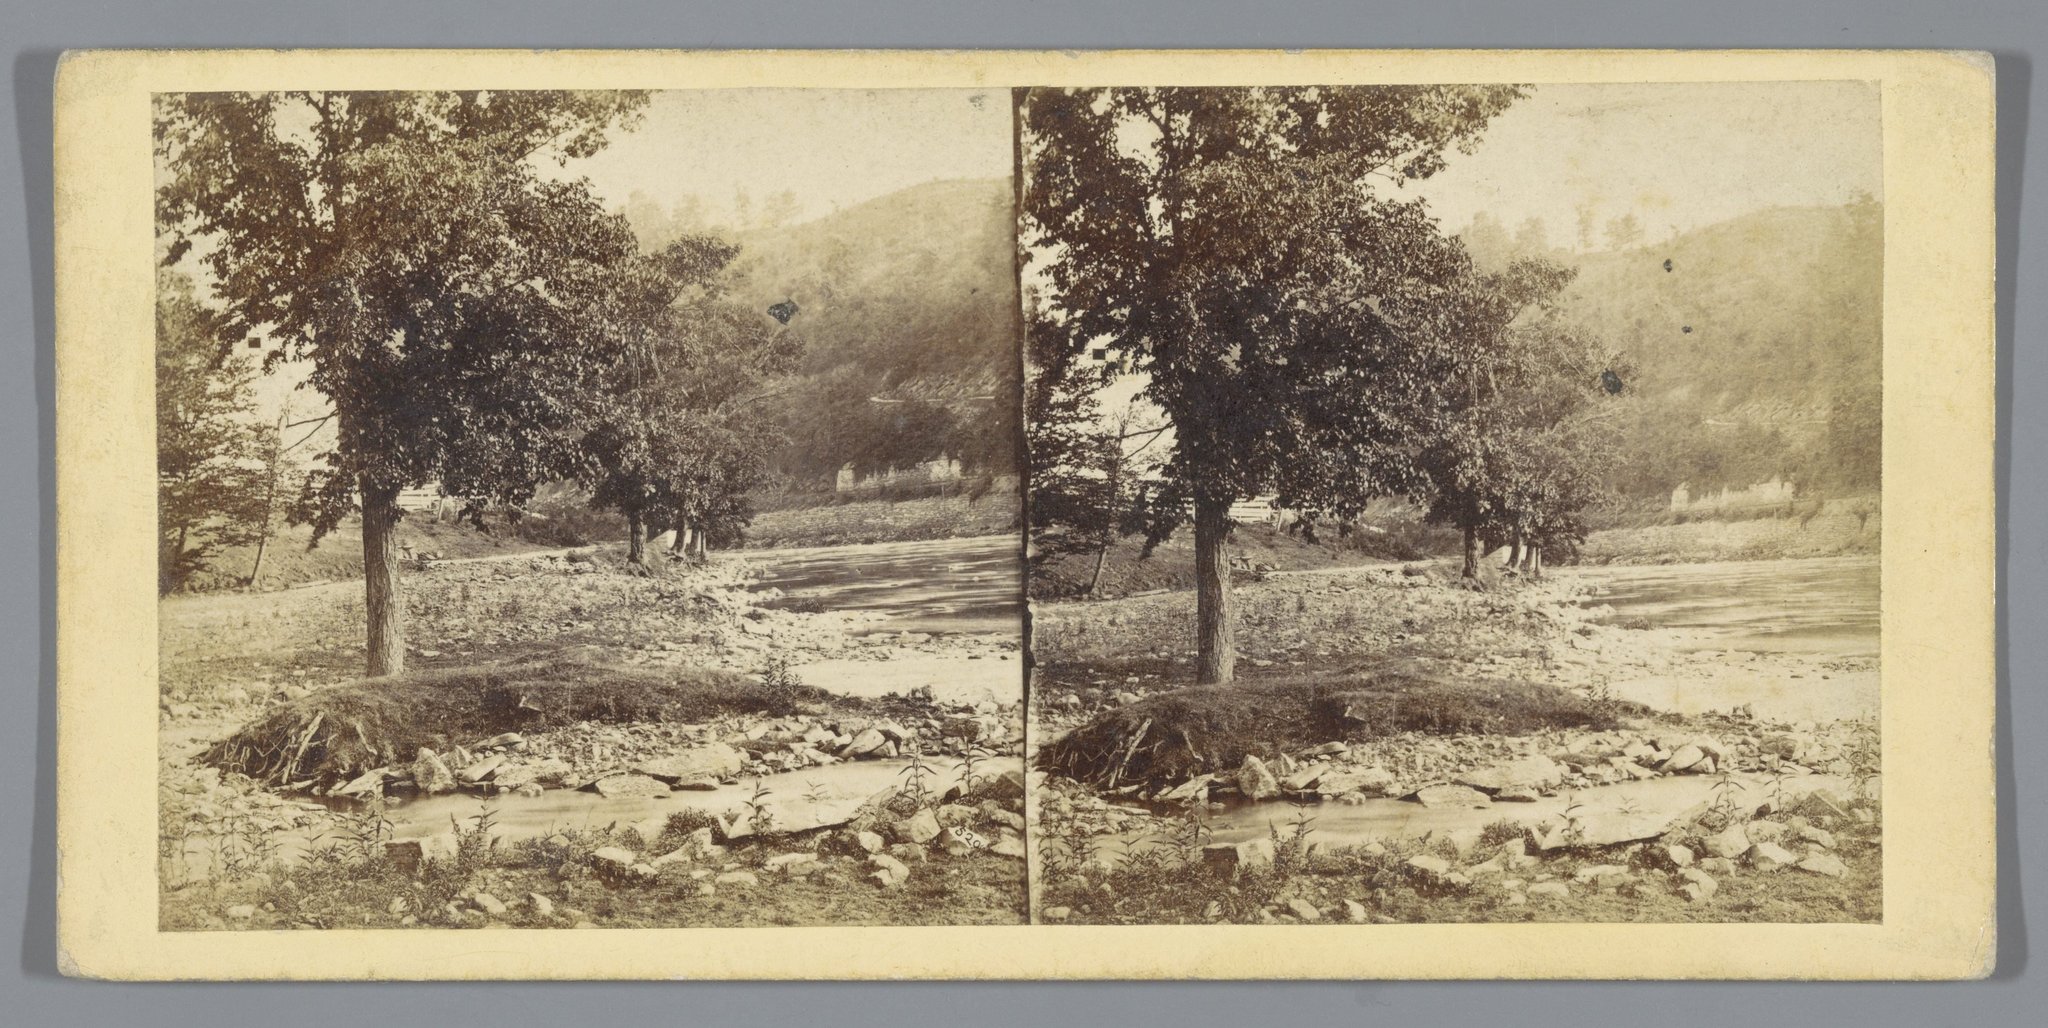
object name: stereograph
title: Spruce Creek stroomt in de Little Juniata River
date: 1859-1862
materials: cardboard, paper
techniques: albumen print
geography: new york city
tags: trees, brook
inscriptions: number: ‘520’, address: ‘501 Broadway, New-York.’